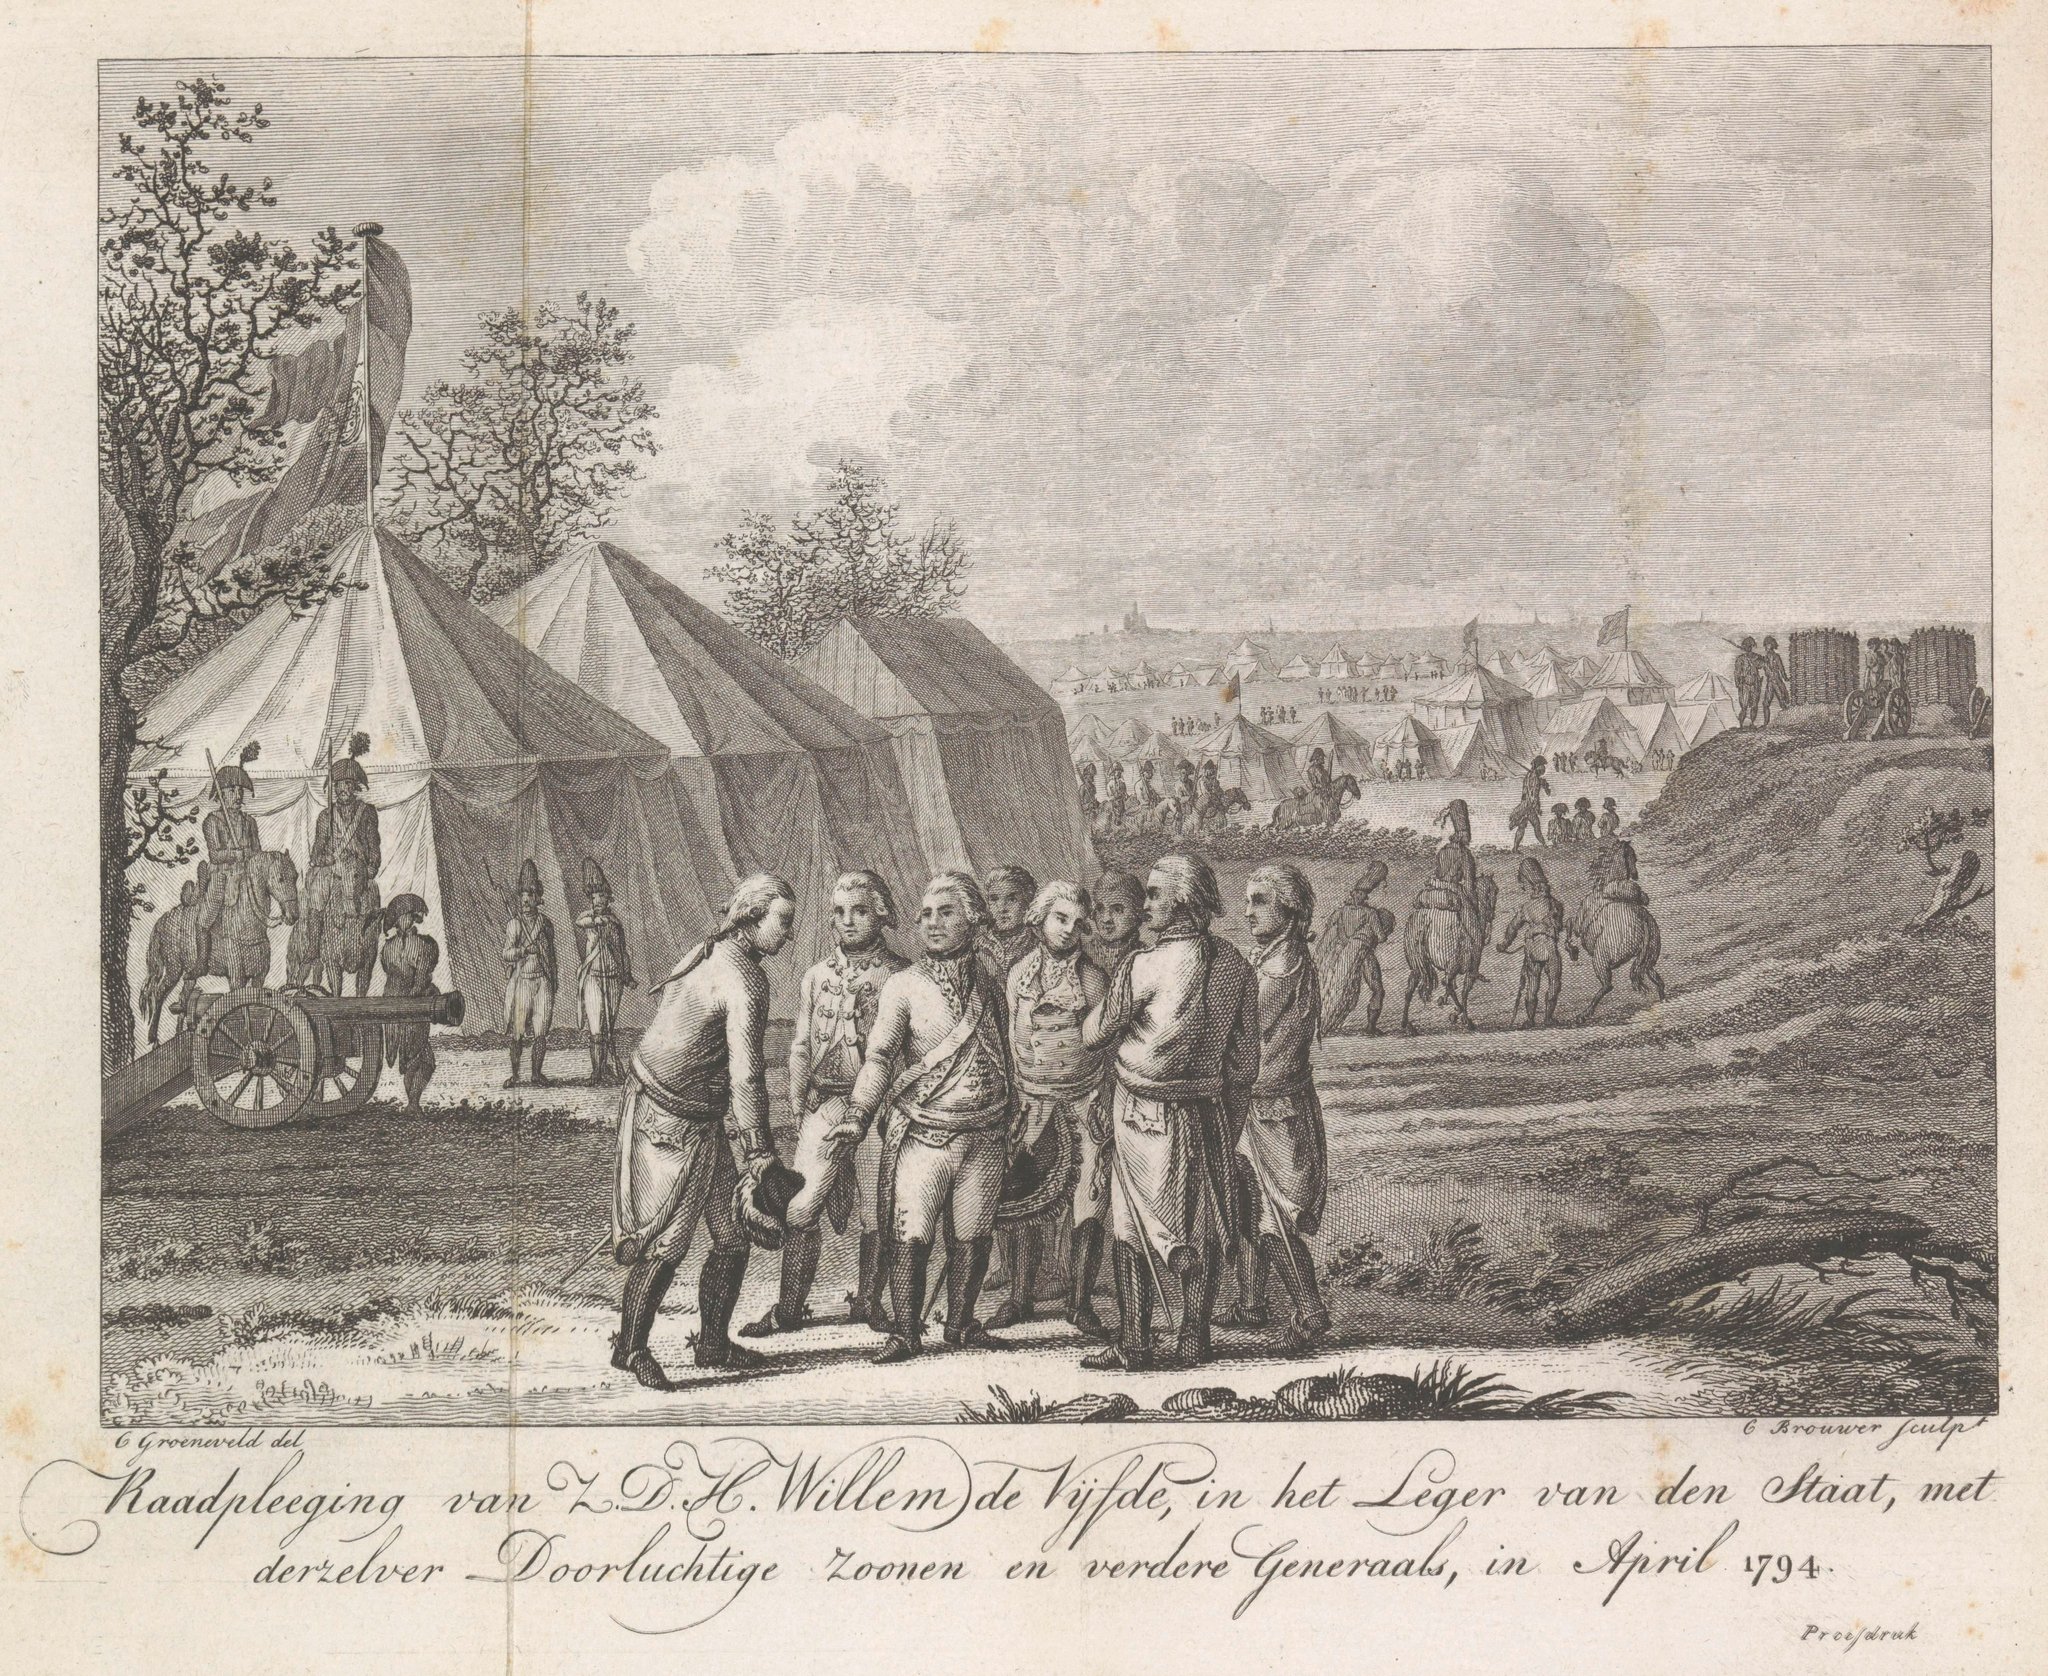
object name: history print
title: Raadpleeging van Z.D.H. Willem de Vijfde, in het Leger van den Staat, met derzelver Doorluchtige zoonen en verdere Generaals, in April 1794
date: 1803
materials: paper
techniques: engraving, etching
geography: netherlands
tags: the hague, william v (prince of orange), william i of the netherlands, willem george frederik (prins van oranje-nassau), (military) camp with tents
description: Stadhouder Willem V met zijn zonen Willem George Frederik en Willem I Frederik in overleg met de generaals, tussen de tenten van het legerkamp in de Zuidelijke Nederlanden, april 1794. Illustratie in het vierdelige Leven van Willem George Fredrik (1802-1803).